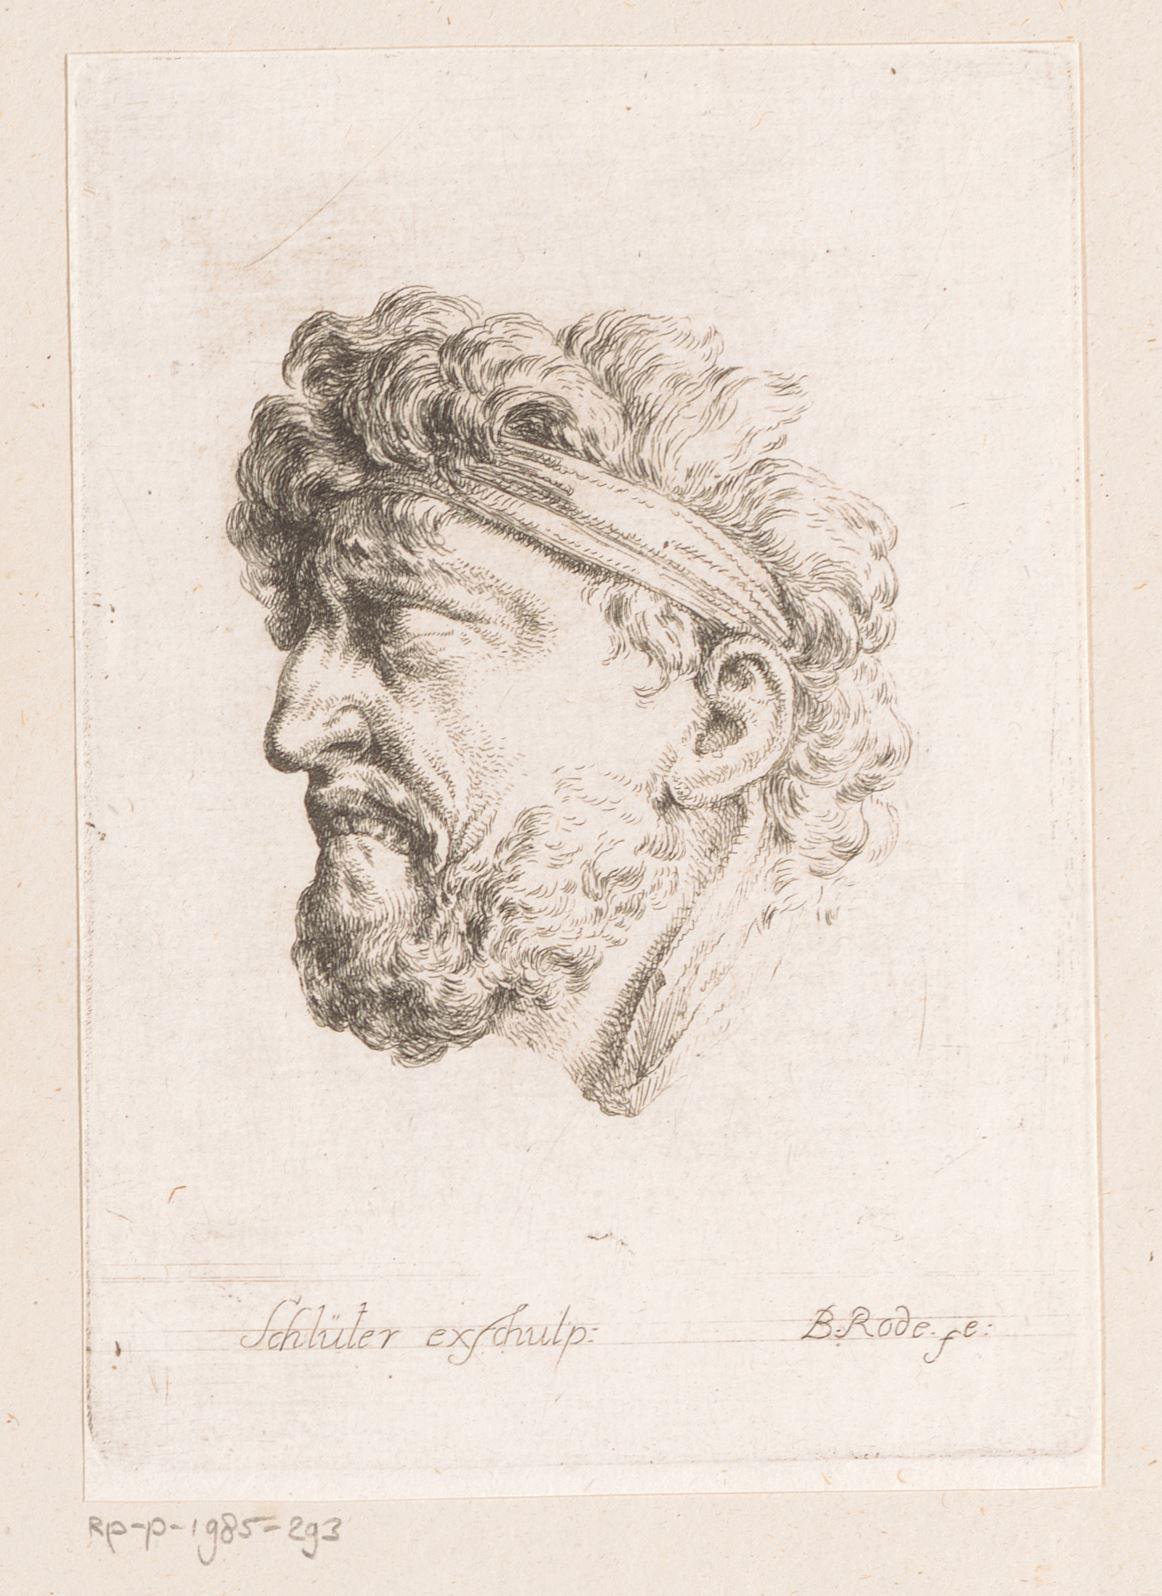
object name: print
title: Mascarons en helmen van het Zeughaus te Berlijn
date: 1759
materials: paper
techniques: etching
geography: berlin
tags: face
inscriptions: collector's mark: Lugt 2760, collector's mark: Lugt 2228